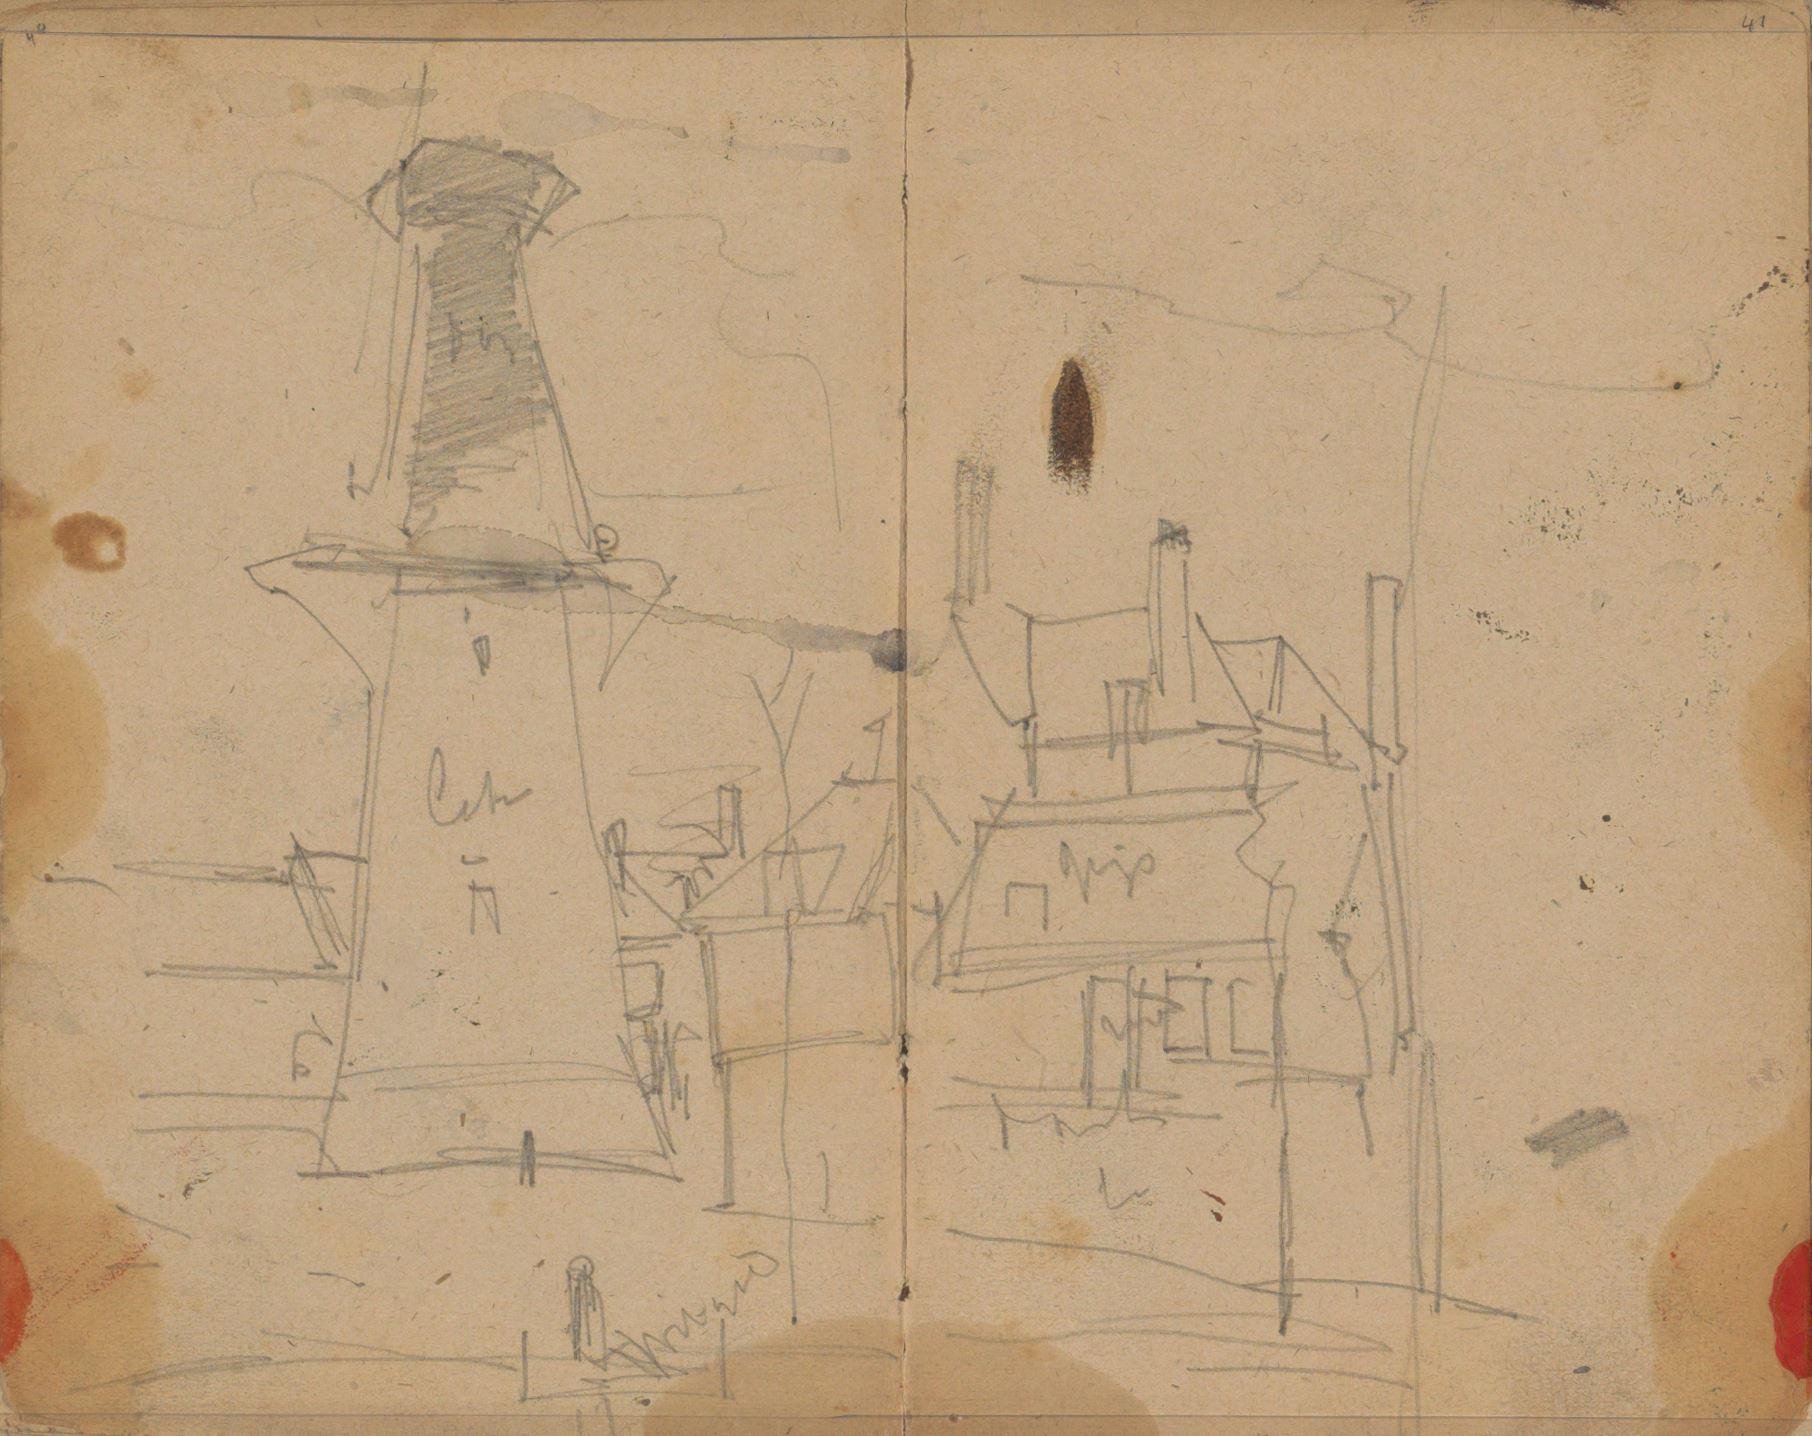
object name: sketchbook leaf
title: Stadsgezicht met een molen, mogelijk Delft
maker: george hendrik breitner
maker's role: draughtsman, painter, print maker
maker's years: 1857-1923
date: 1881-1883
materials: paper, pencil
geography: delft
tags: urban housing, city-view, and landscape with man-made constructions, windmill, delft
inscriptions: kleurnotitie, handgeschreven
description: Stadsgezicht met een molen, mogelijk Delft. Pagina 40 en pagina 41 uit een schetsboek met 70 bladen.